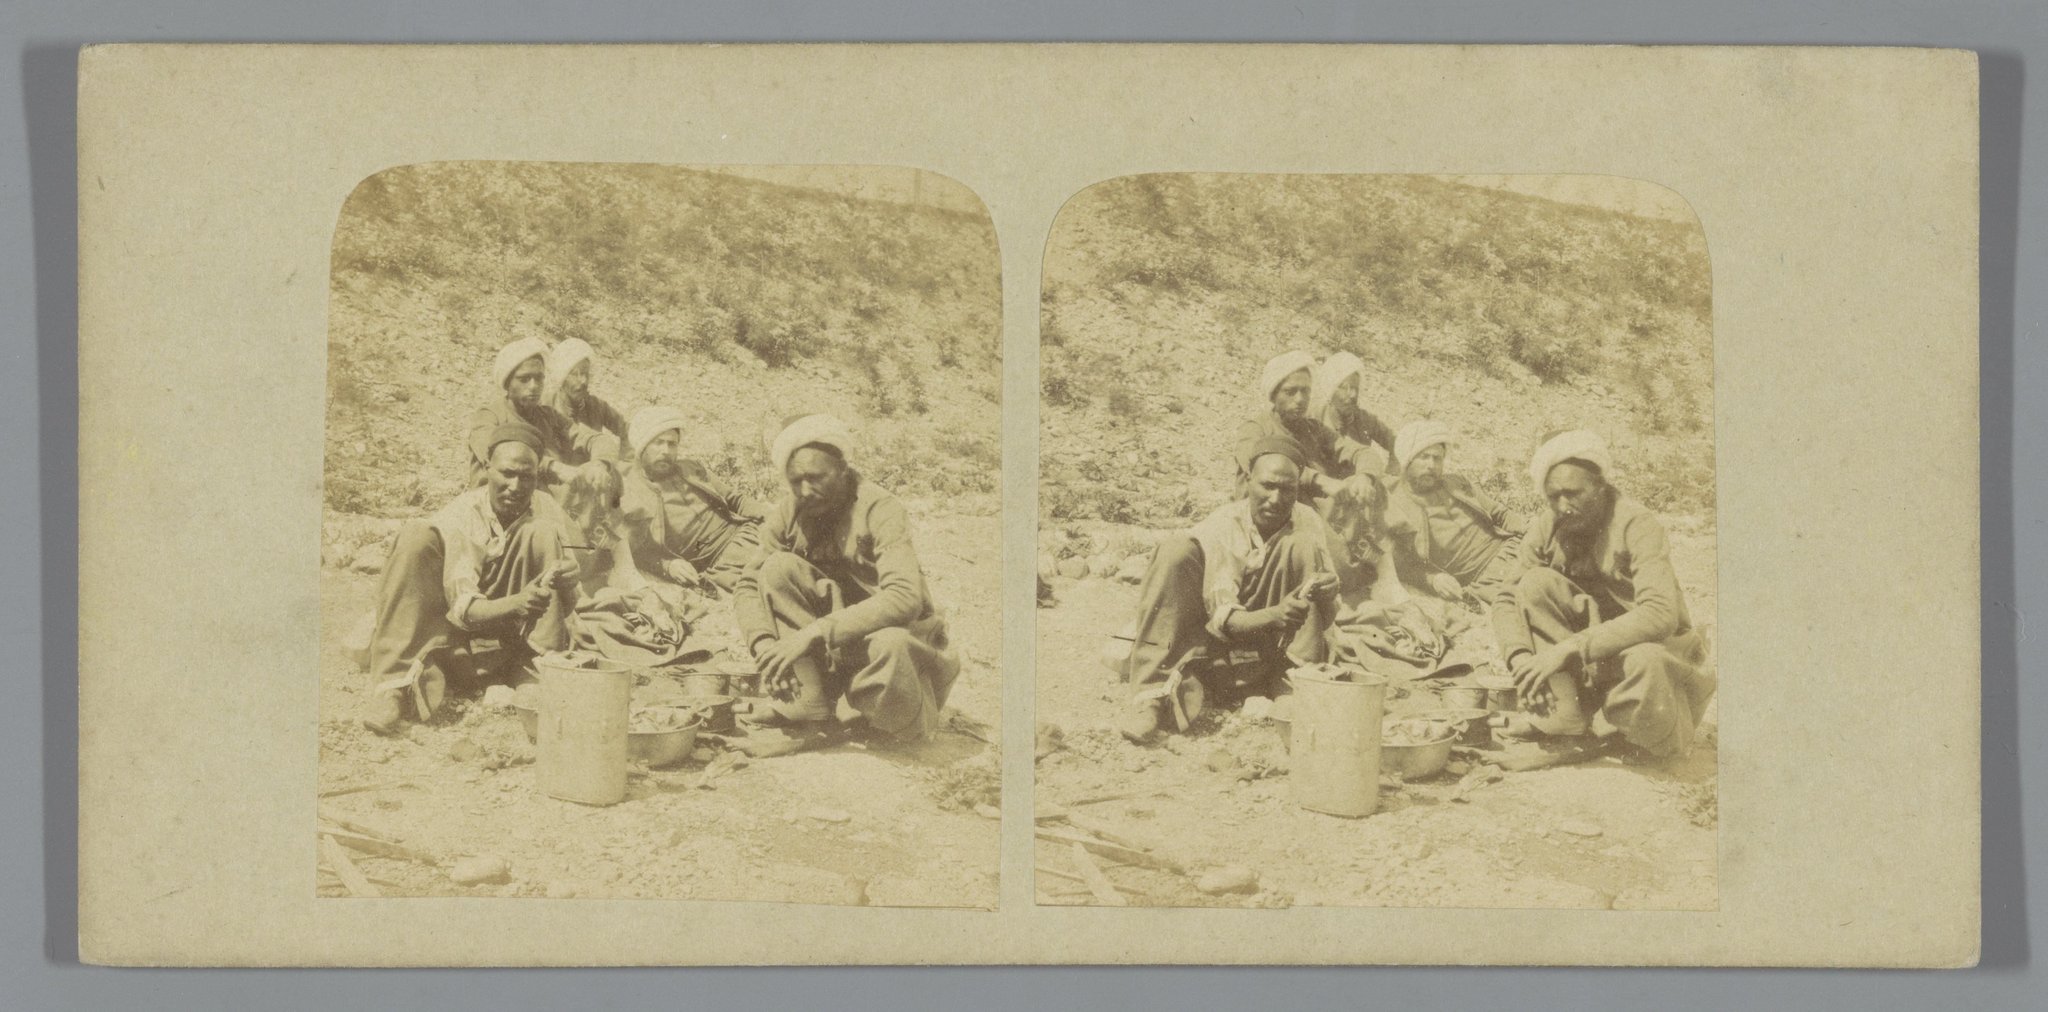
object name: stereograph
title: Groep Zouaven tijdens de Tweede Italiaanse Onafhankelijkheidsoorlog, vlak voor of vlak na de Slag bij Palestro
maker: Anonymous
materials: cardboard, paper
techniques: albumen print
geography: italy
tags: the soldier; the soldier's life